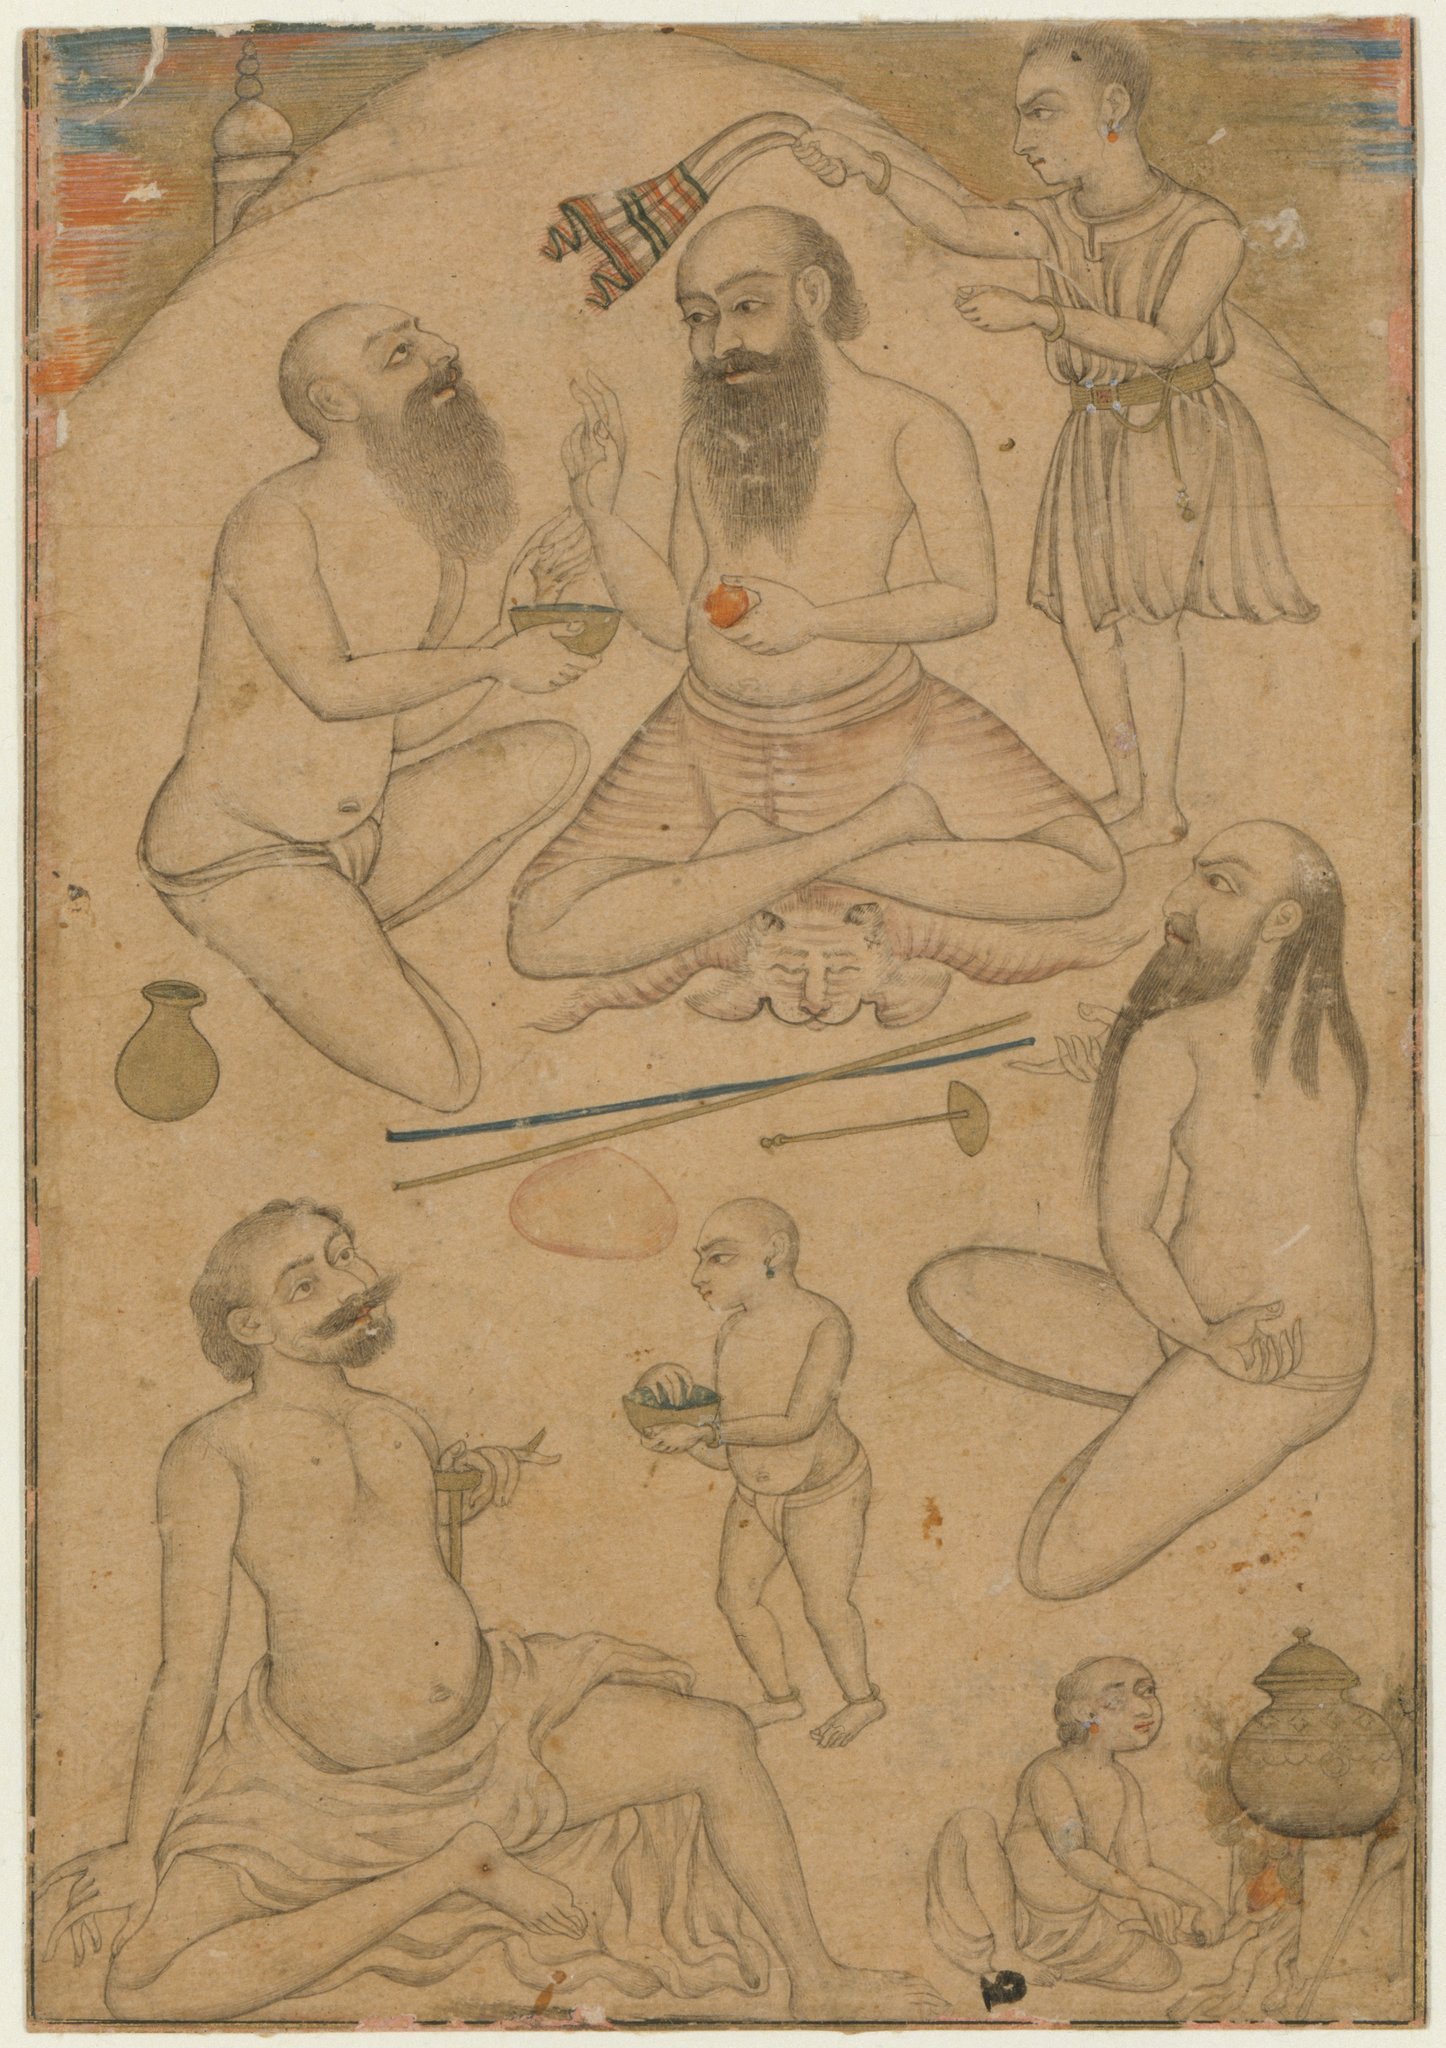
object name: painting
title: An Encampment of Yogis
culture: indian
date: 1660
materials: ink, paper, watercolor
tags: men